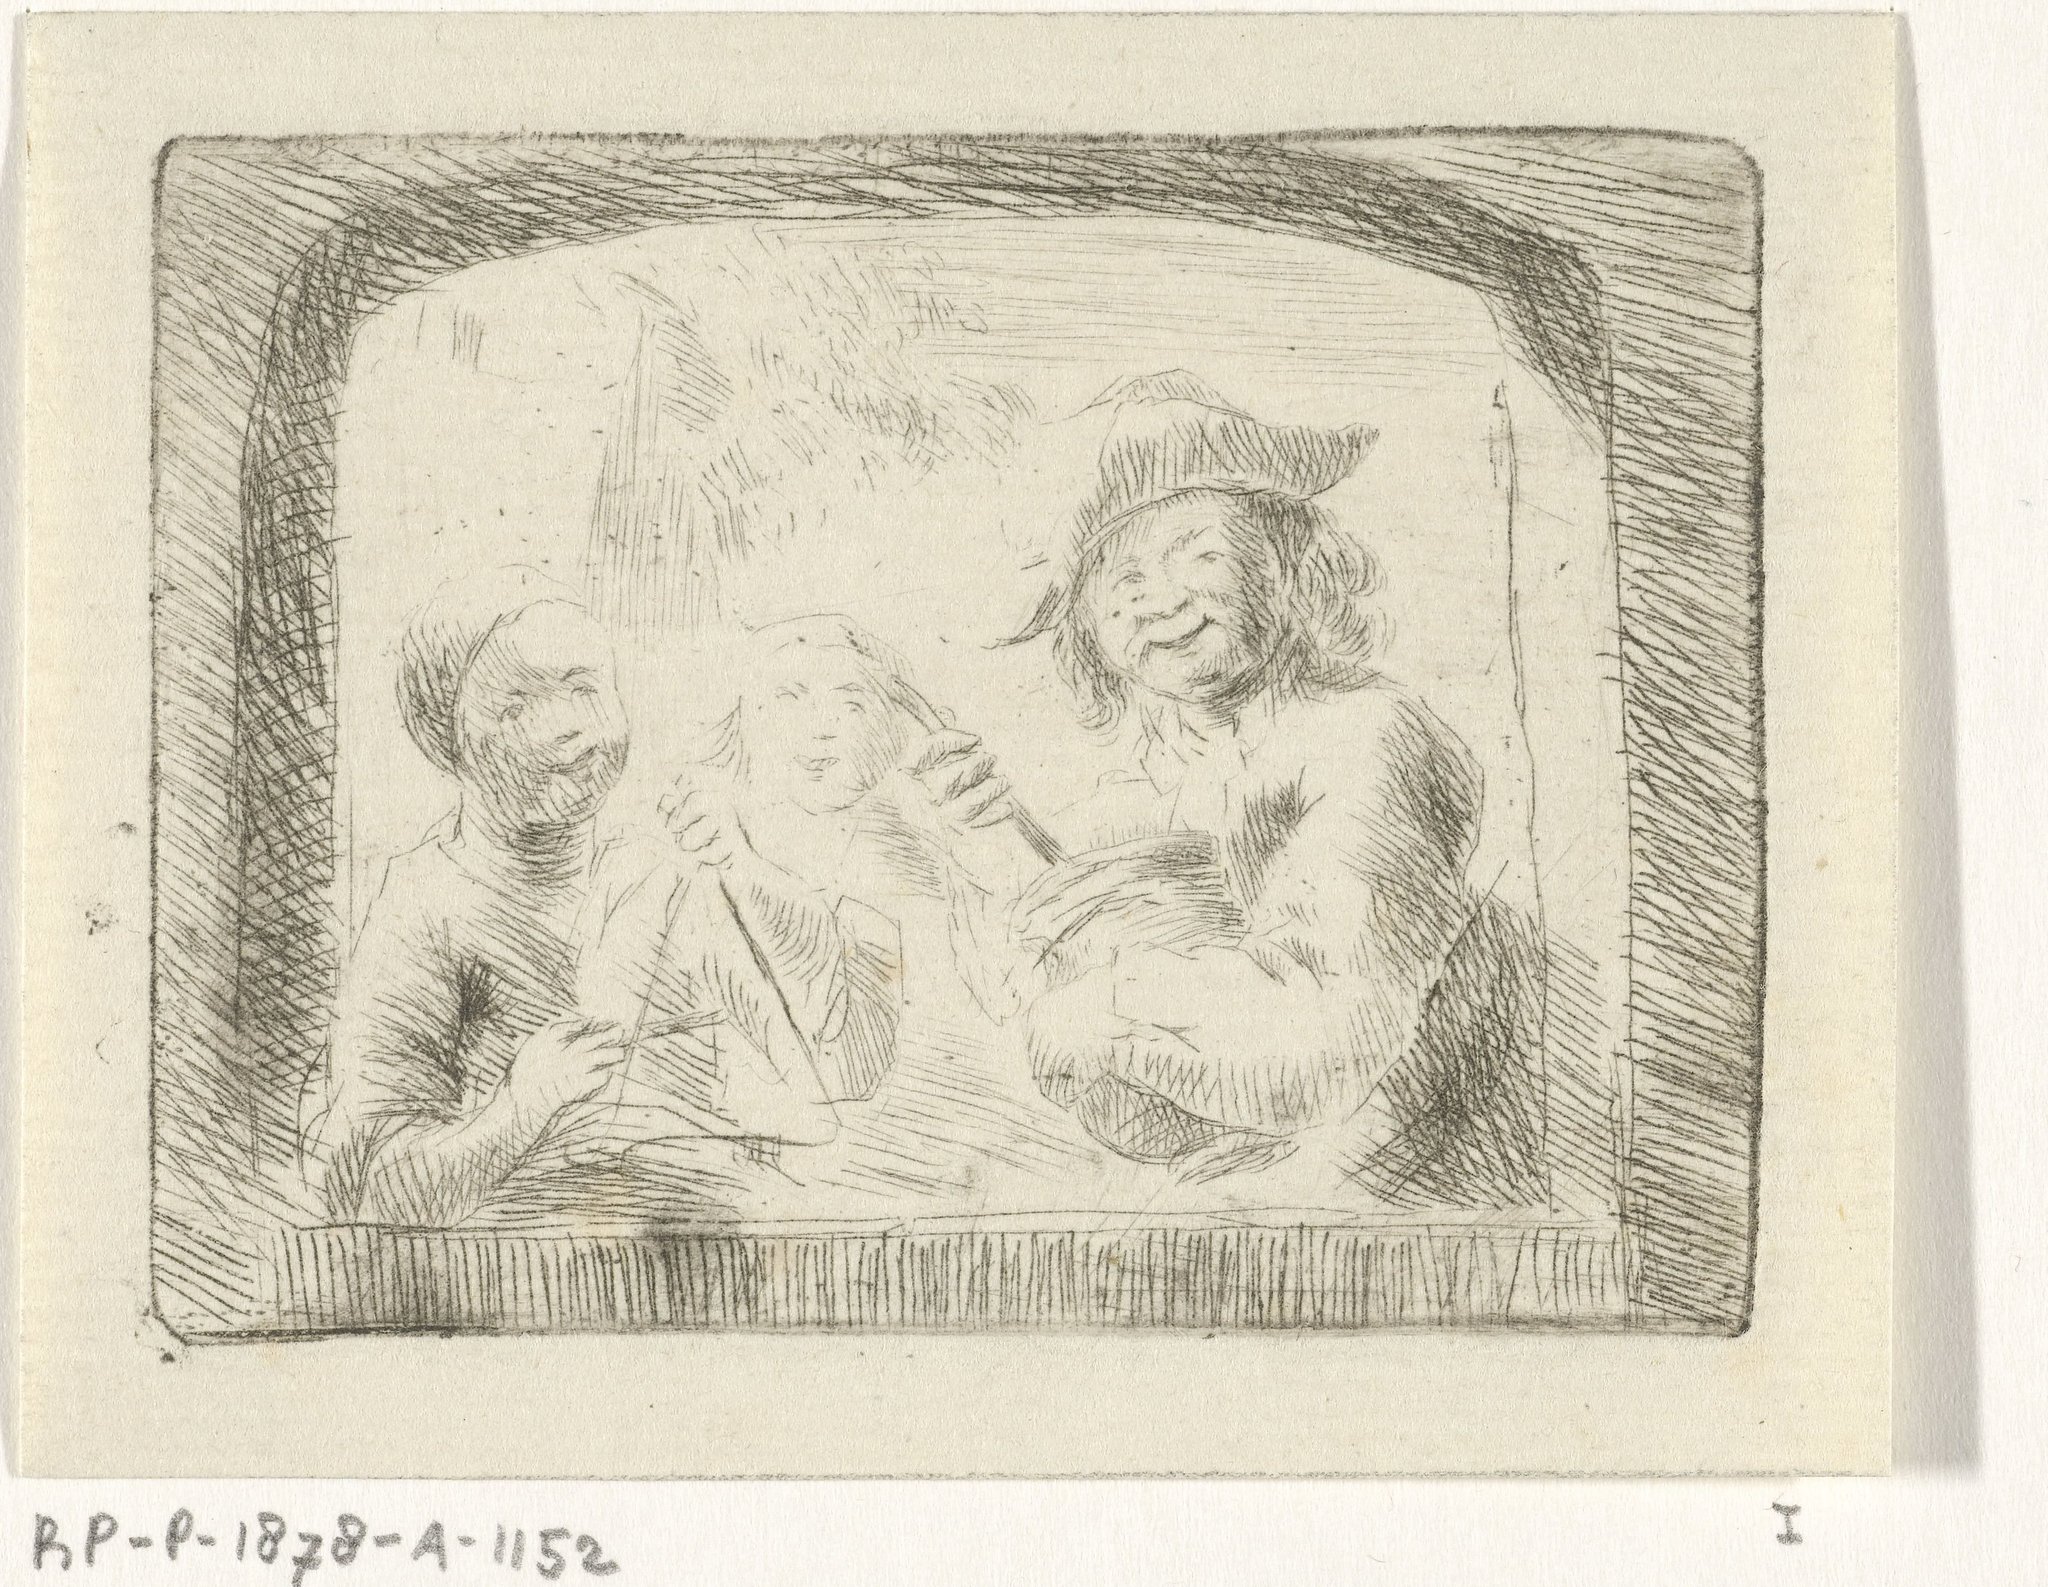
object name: print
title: Rommelpotspeler en twee kinderen in een nis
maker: simon klapmuts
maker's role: print maker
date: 1744-1780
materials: paper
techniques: etching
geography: moordrecht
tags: improvised musical instruments: rumbling pot, other percussion instruments (with name)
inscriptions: collector's mark: Lugt 2165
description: In een nis staan een jongen met een rommelpot, een meisje met een triangel en een tweede meisje.